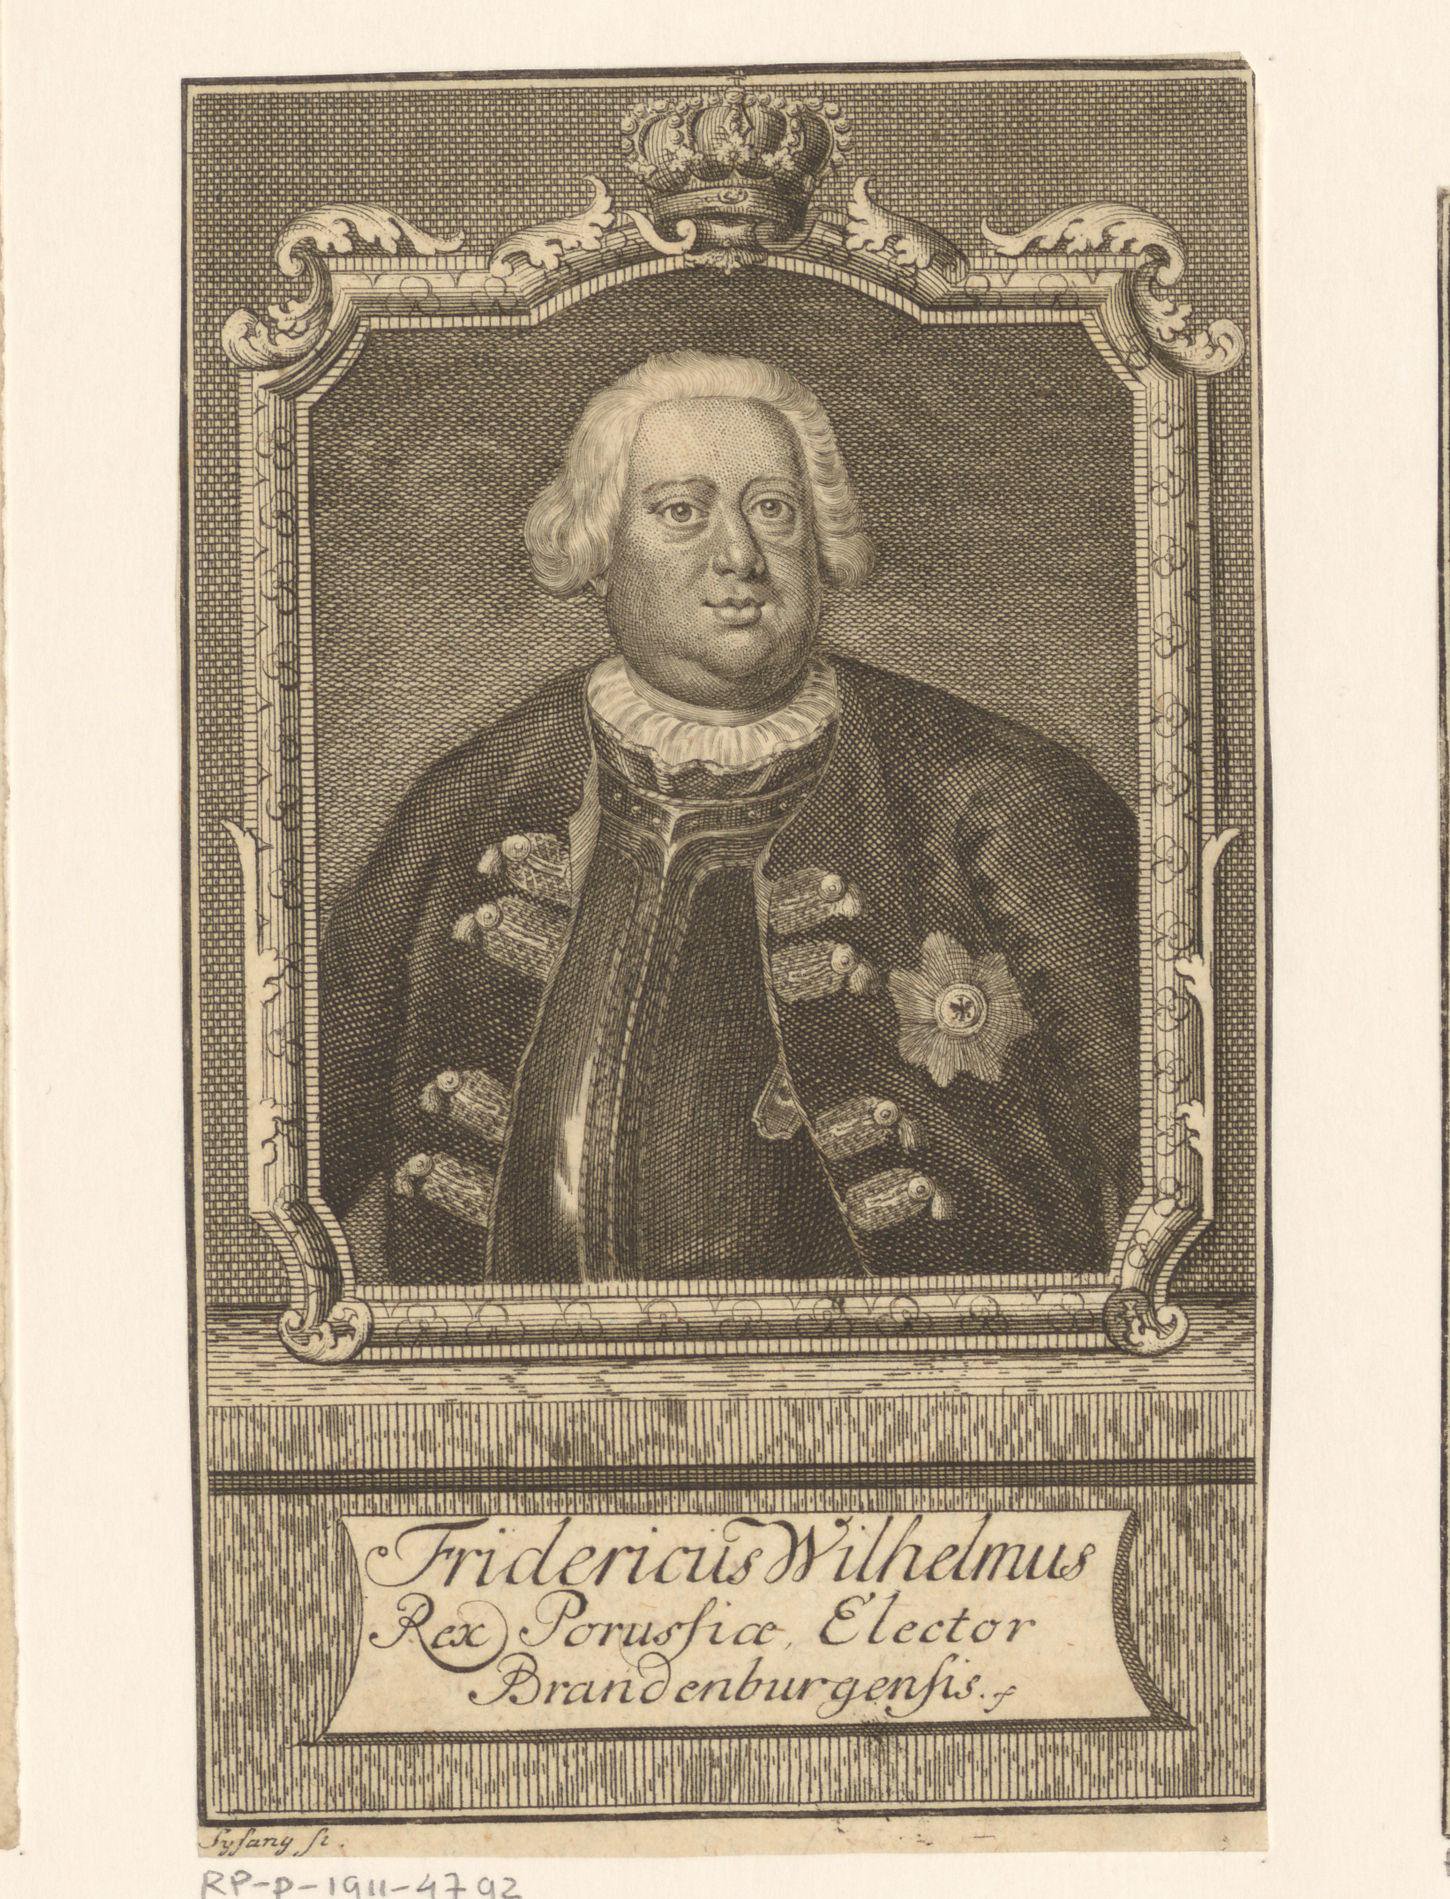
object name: print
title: Portret van Frederik Willem I, koning van Pruisen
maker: johann christoph sysang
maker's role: print maker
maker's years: 1703-1757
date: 1713-1757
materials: paper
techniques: engraving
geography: germany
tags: berlin, frederik willem i koning van pruisen, historical persons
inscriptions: collector's mark: Lugt 2228